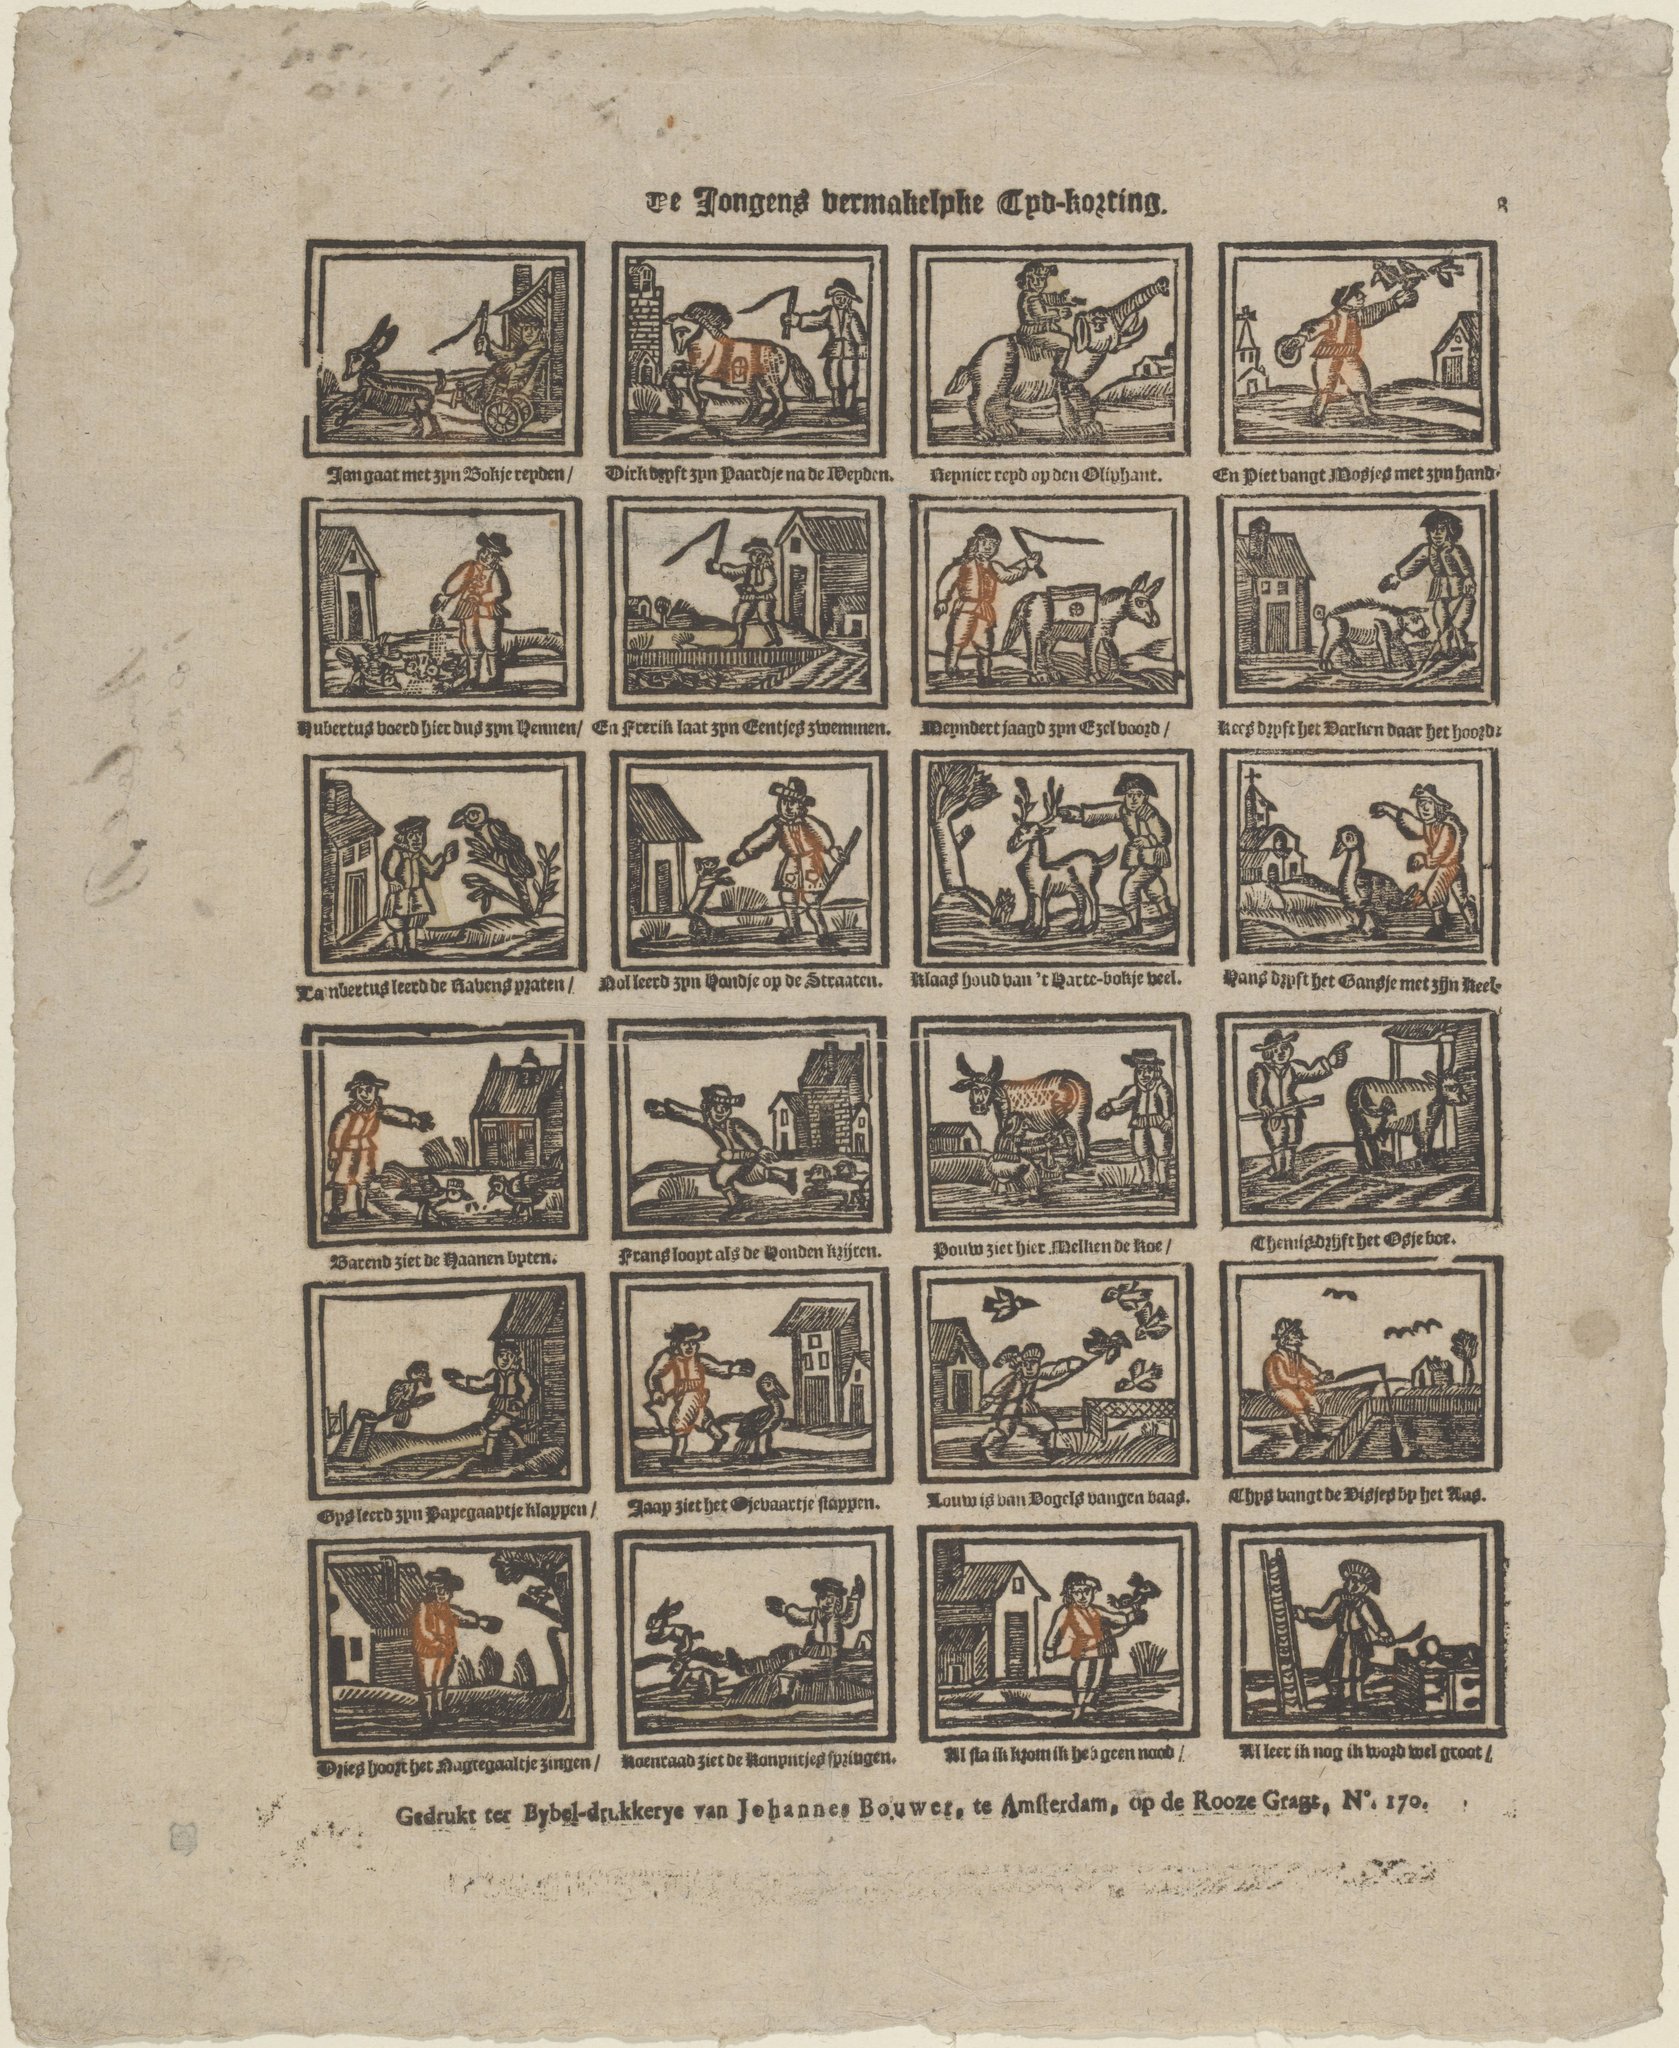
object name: print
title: De jongens vermakelyke tyd-korting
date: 1805-1808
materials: paper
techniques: colour, letterpress printing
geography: amsterdam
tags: animals, birds, child playing with animals, trunked animals: elephant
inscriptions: collector's mark: Lugt 2760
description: Blad met 24 voorstellingen van verschillende bezigheden met dieren, waaronder kippen voeren, rijden op een olifant en luisteren naar een zingende nachtegaal. Onder elke afbeelding een vers. Genummerd rechtsboven: 8.